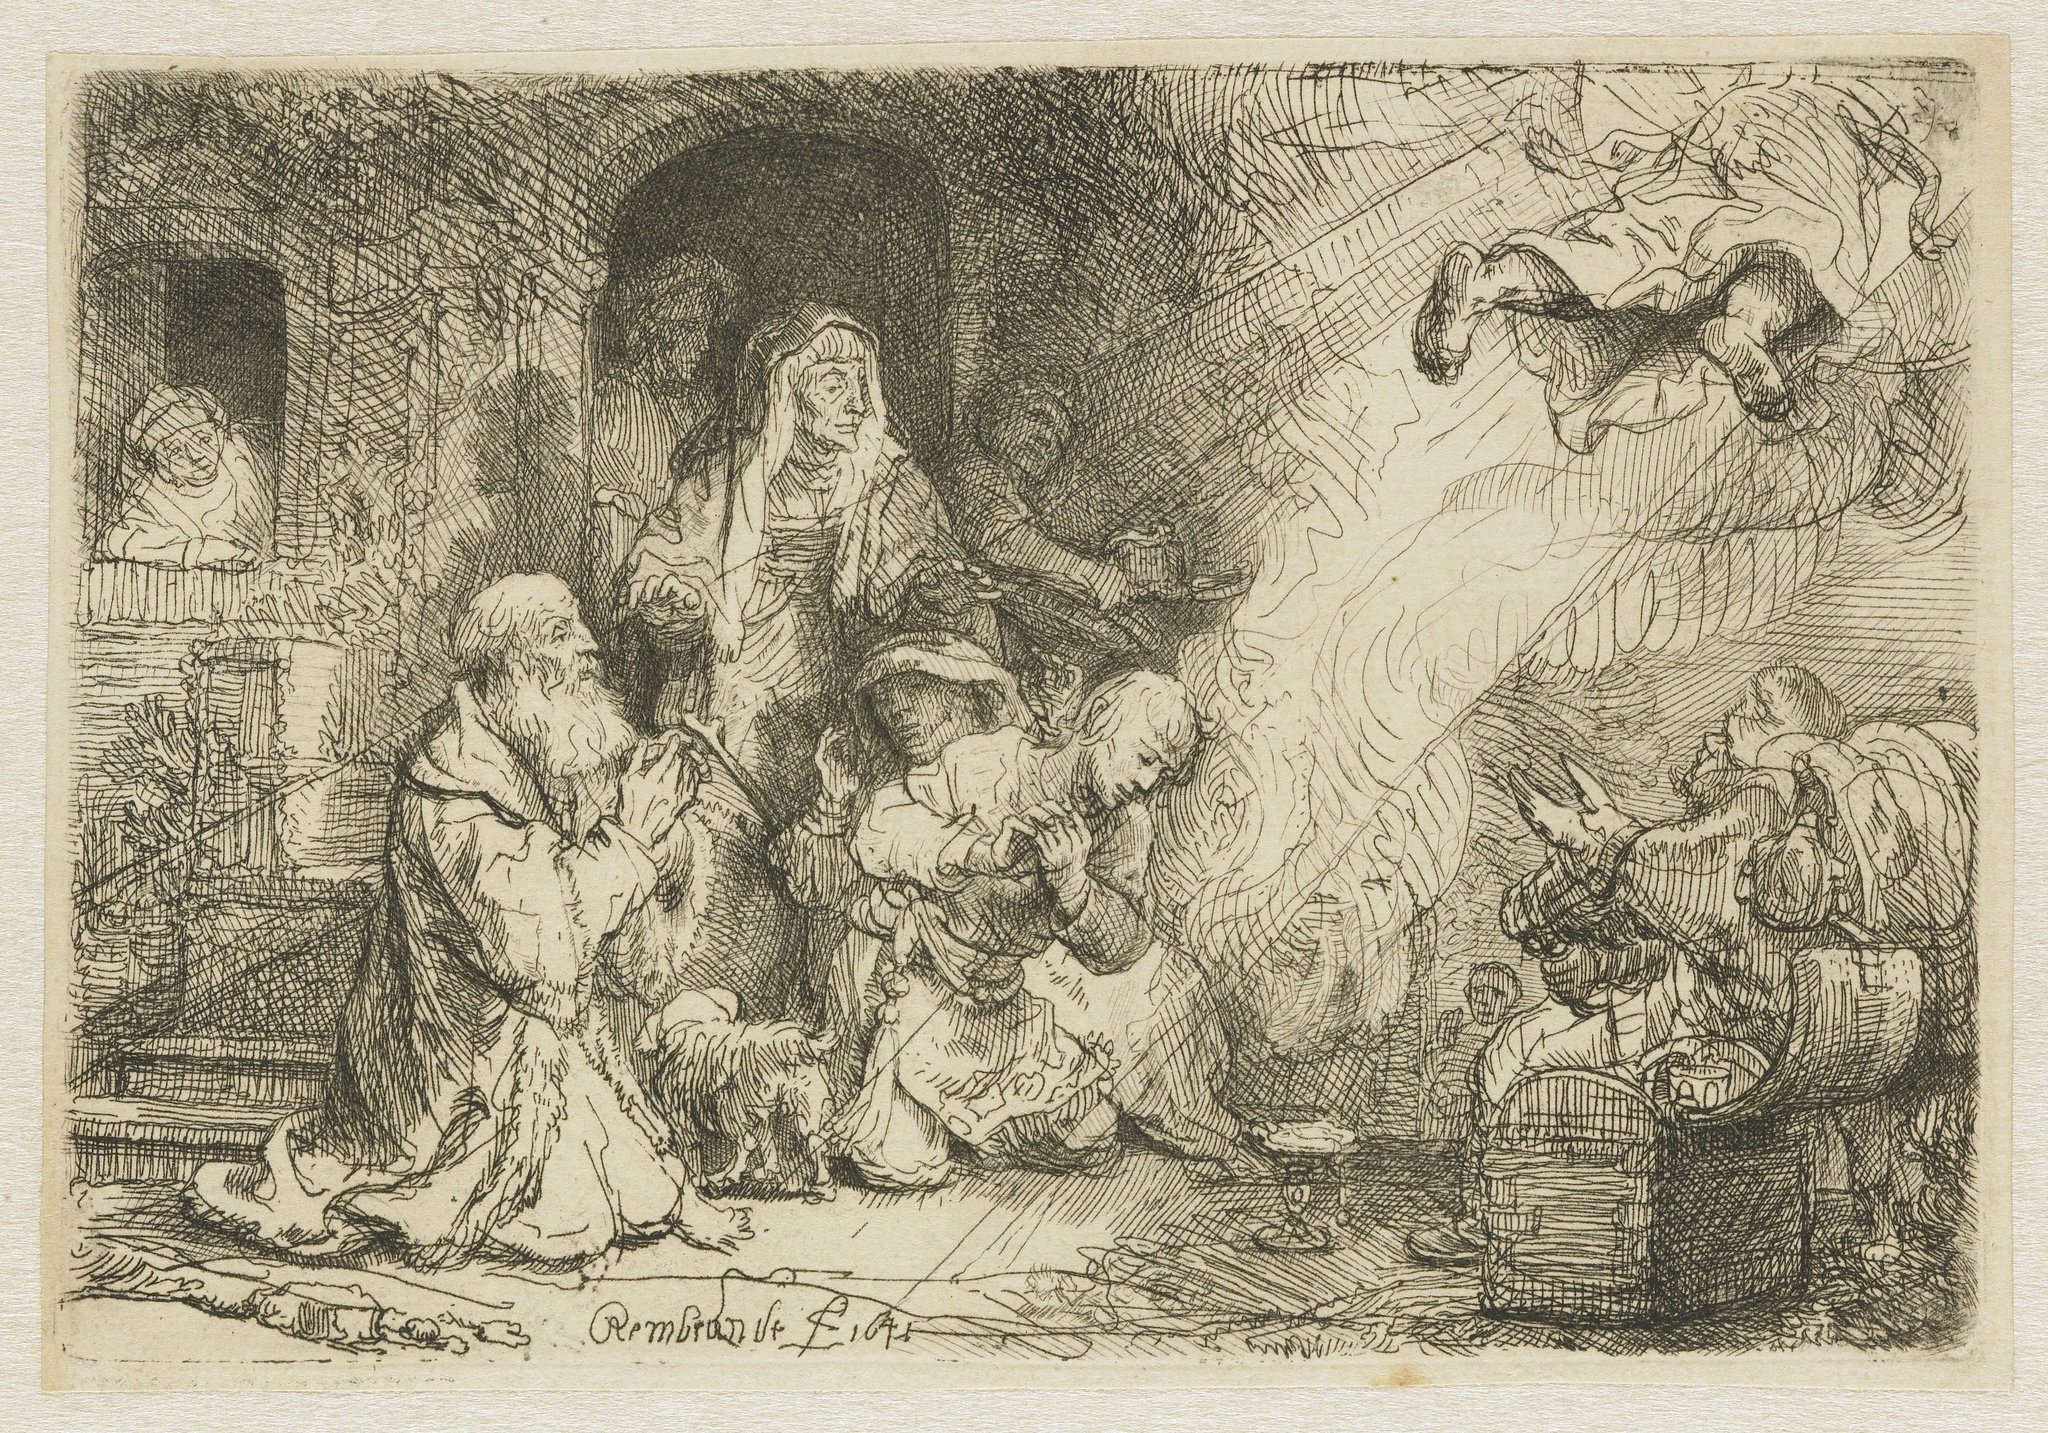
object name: print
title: The angel departing from the family of Tobias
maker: rembrandt van rijn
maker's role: draughtsman, painter, print maker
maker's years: 1606-1669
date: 1641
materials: paper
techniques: drypoint, etching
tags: other scenes ~ the book of tobit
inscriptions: signature and date: ‘Rembrandt f 1641’, collector's mark: Lugt 2228 a